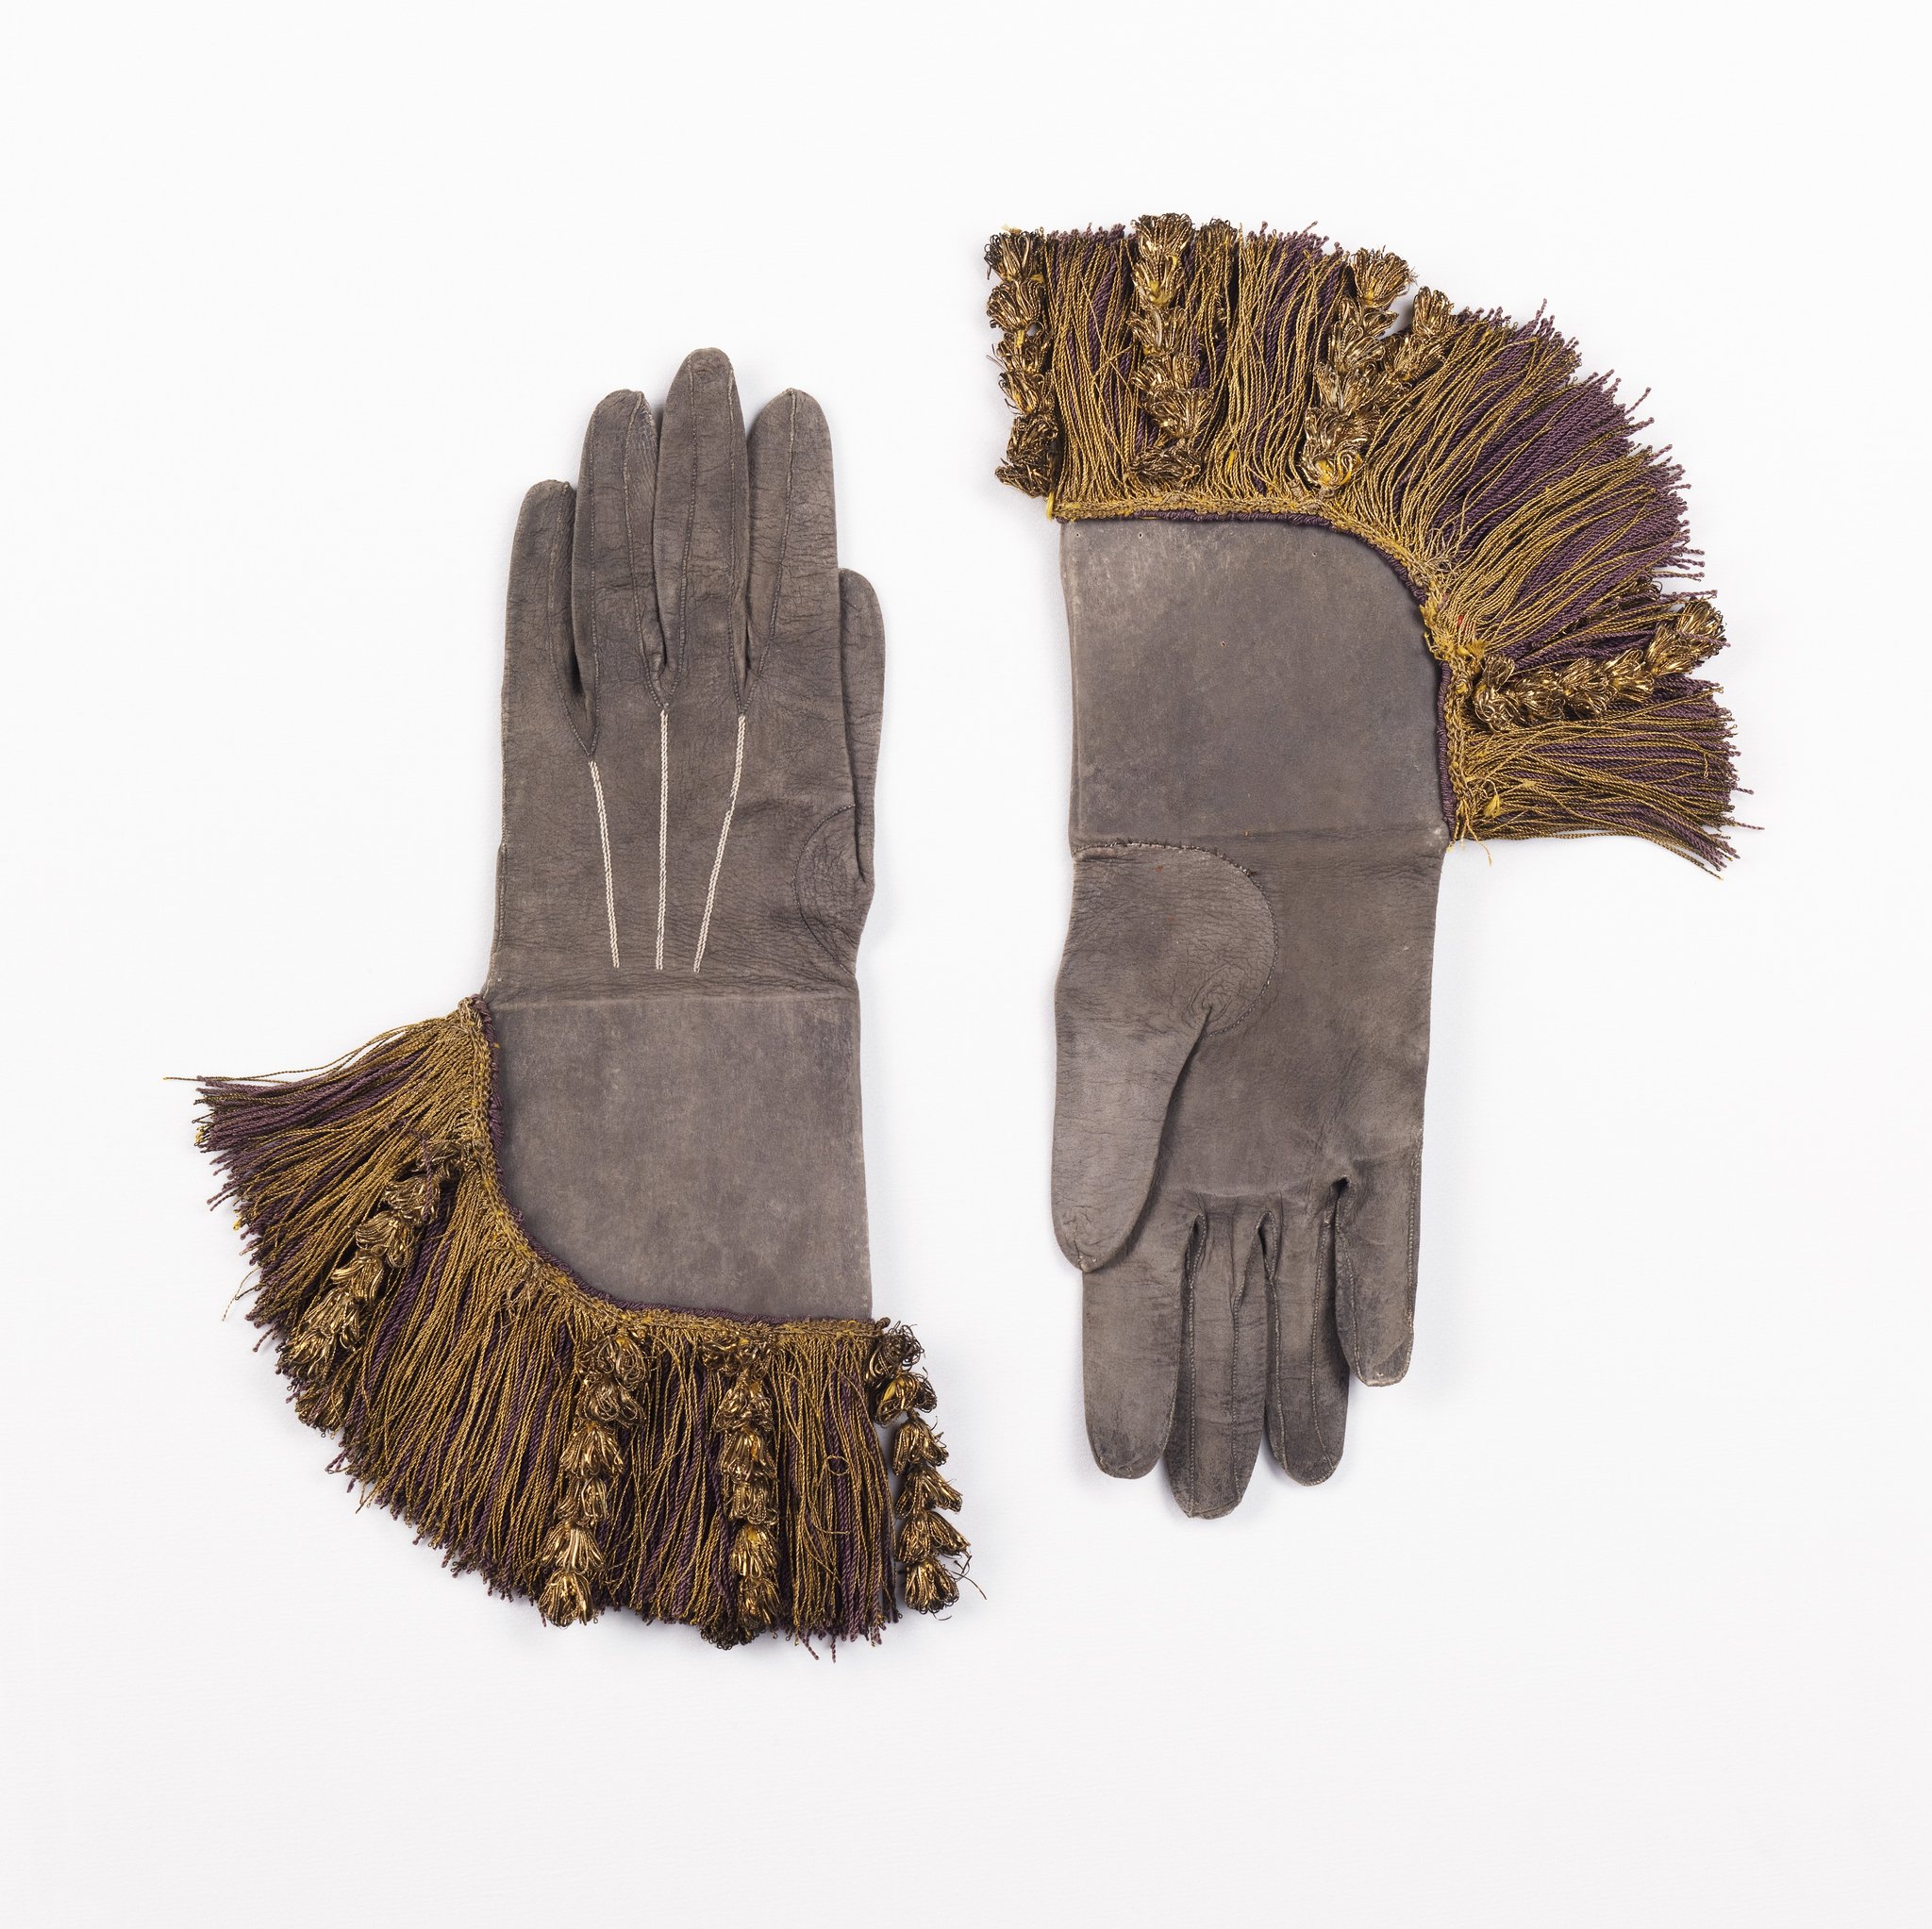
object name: gauntlet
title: Gauntlets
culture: british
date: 1680-1710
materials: leather, metal, silk